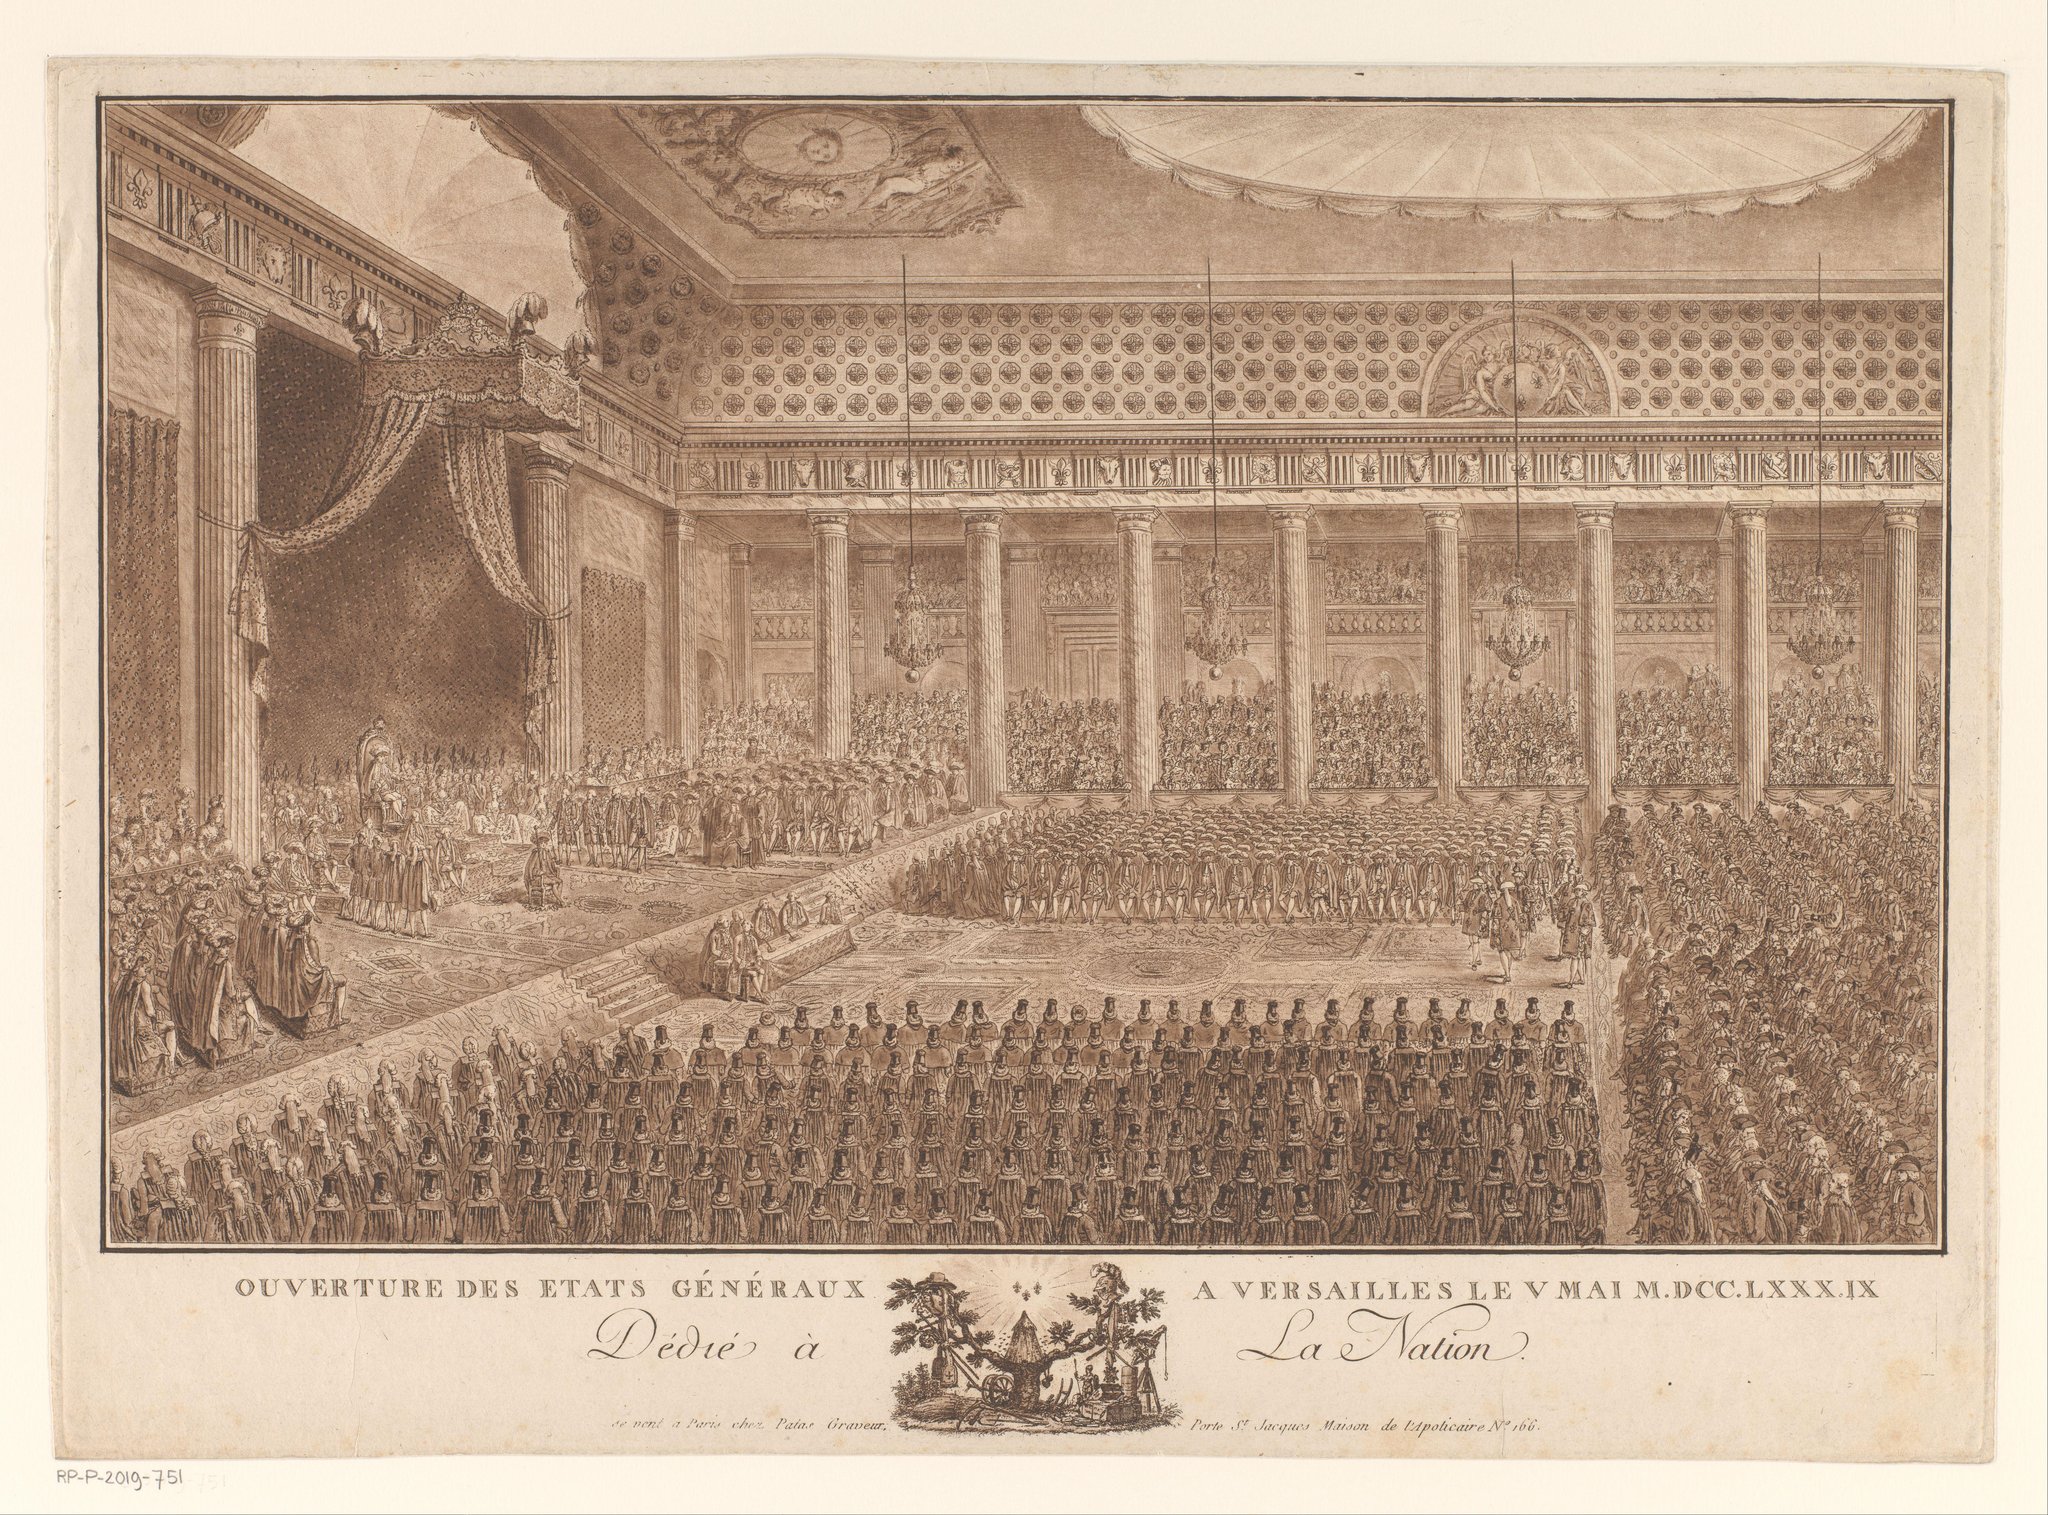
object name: print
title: Ouverture des etats généraux a Versailles le V mai MDCCLXXXIX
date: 1789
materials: paper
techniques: aquatint, engraving, etching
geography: paris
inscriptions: collector's mark: Lugt 2228